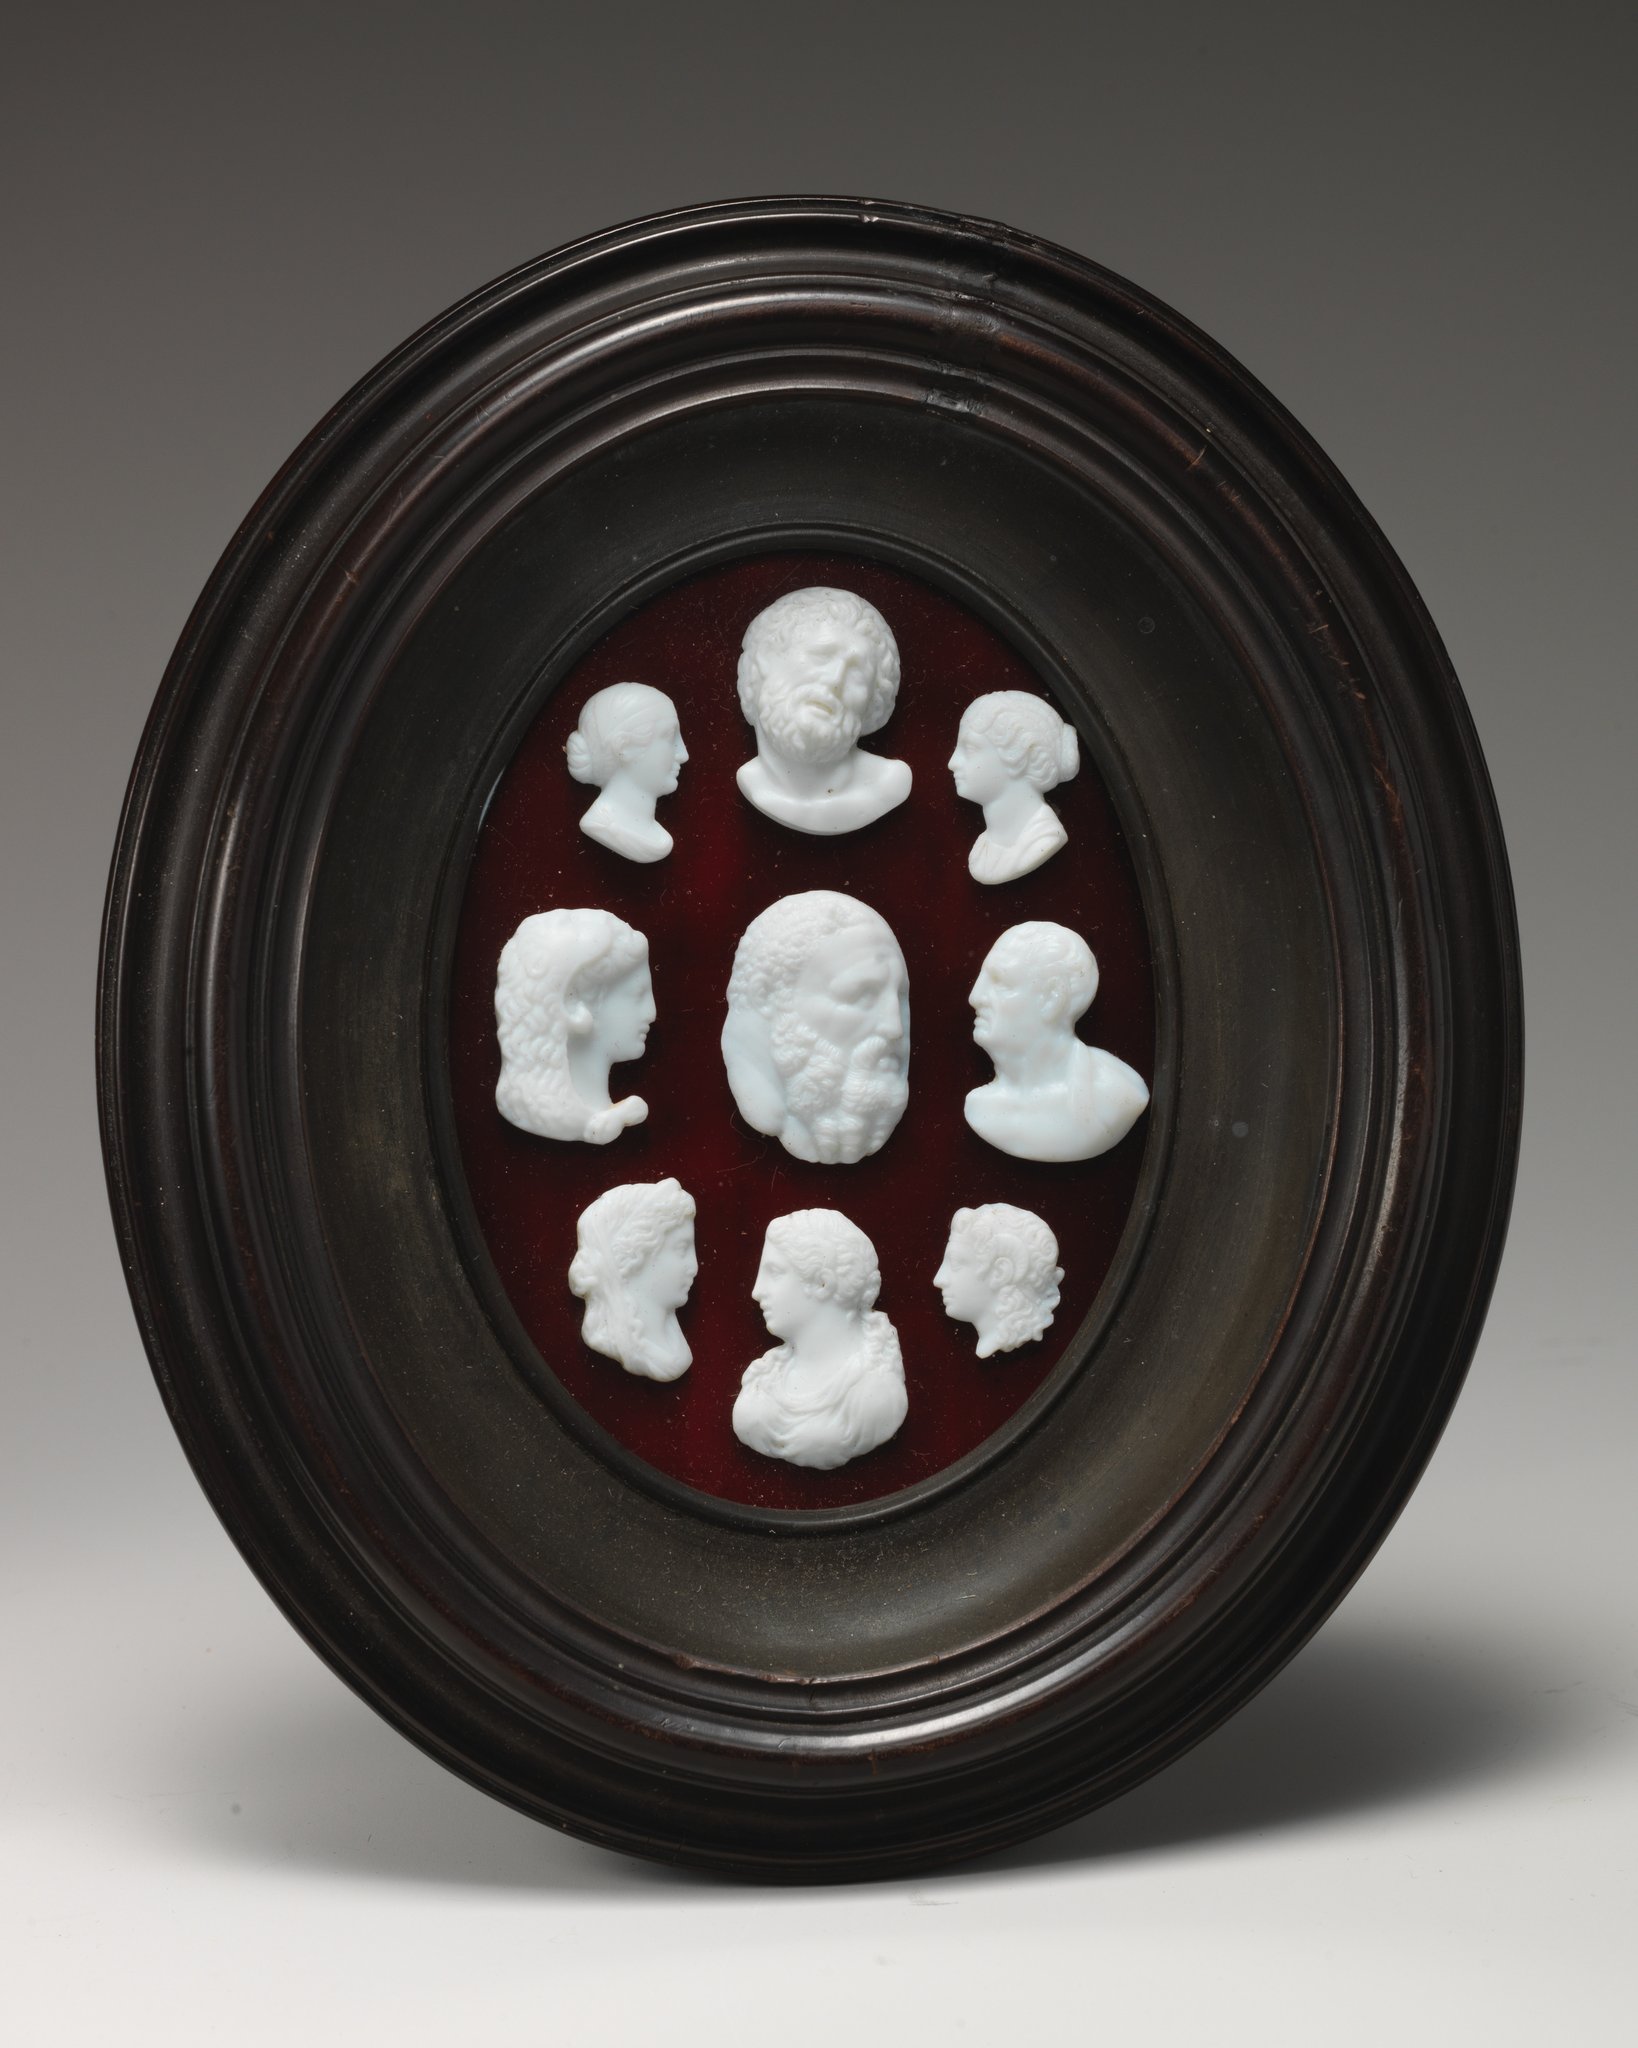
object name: cast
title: Casts from antique gems (9)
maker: james tassie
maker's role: artist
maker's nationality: british, scottish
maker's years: 1735-1799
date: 1767-1800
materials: glass, paste, wood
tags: heads,men,profiles,women